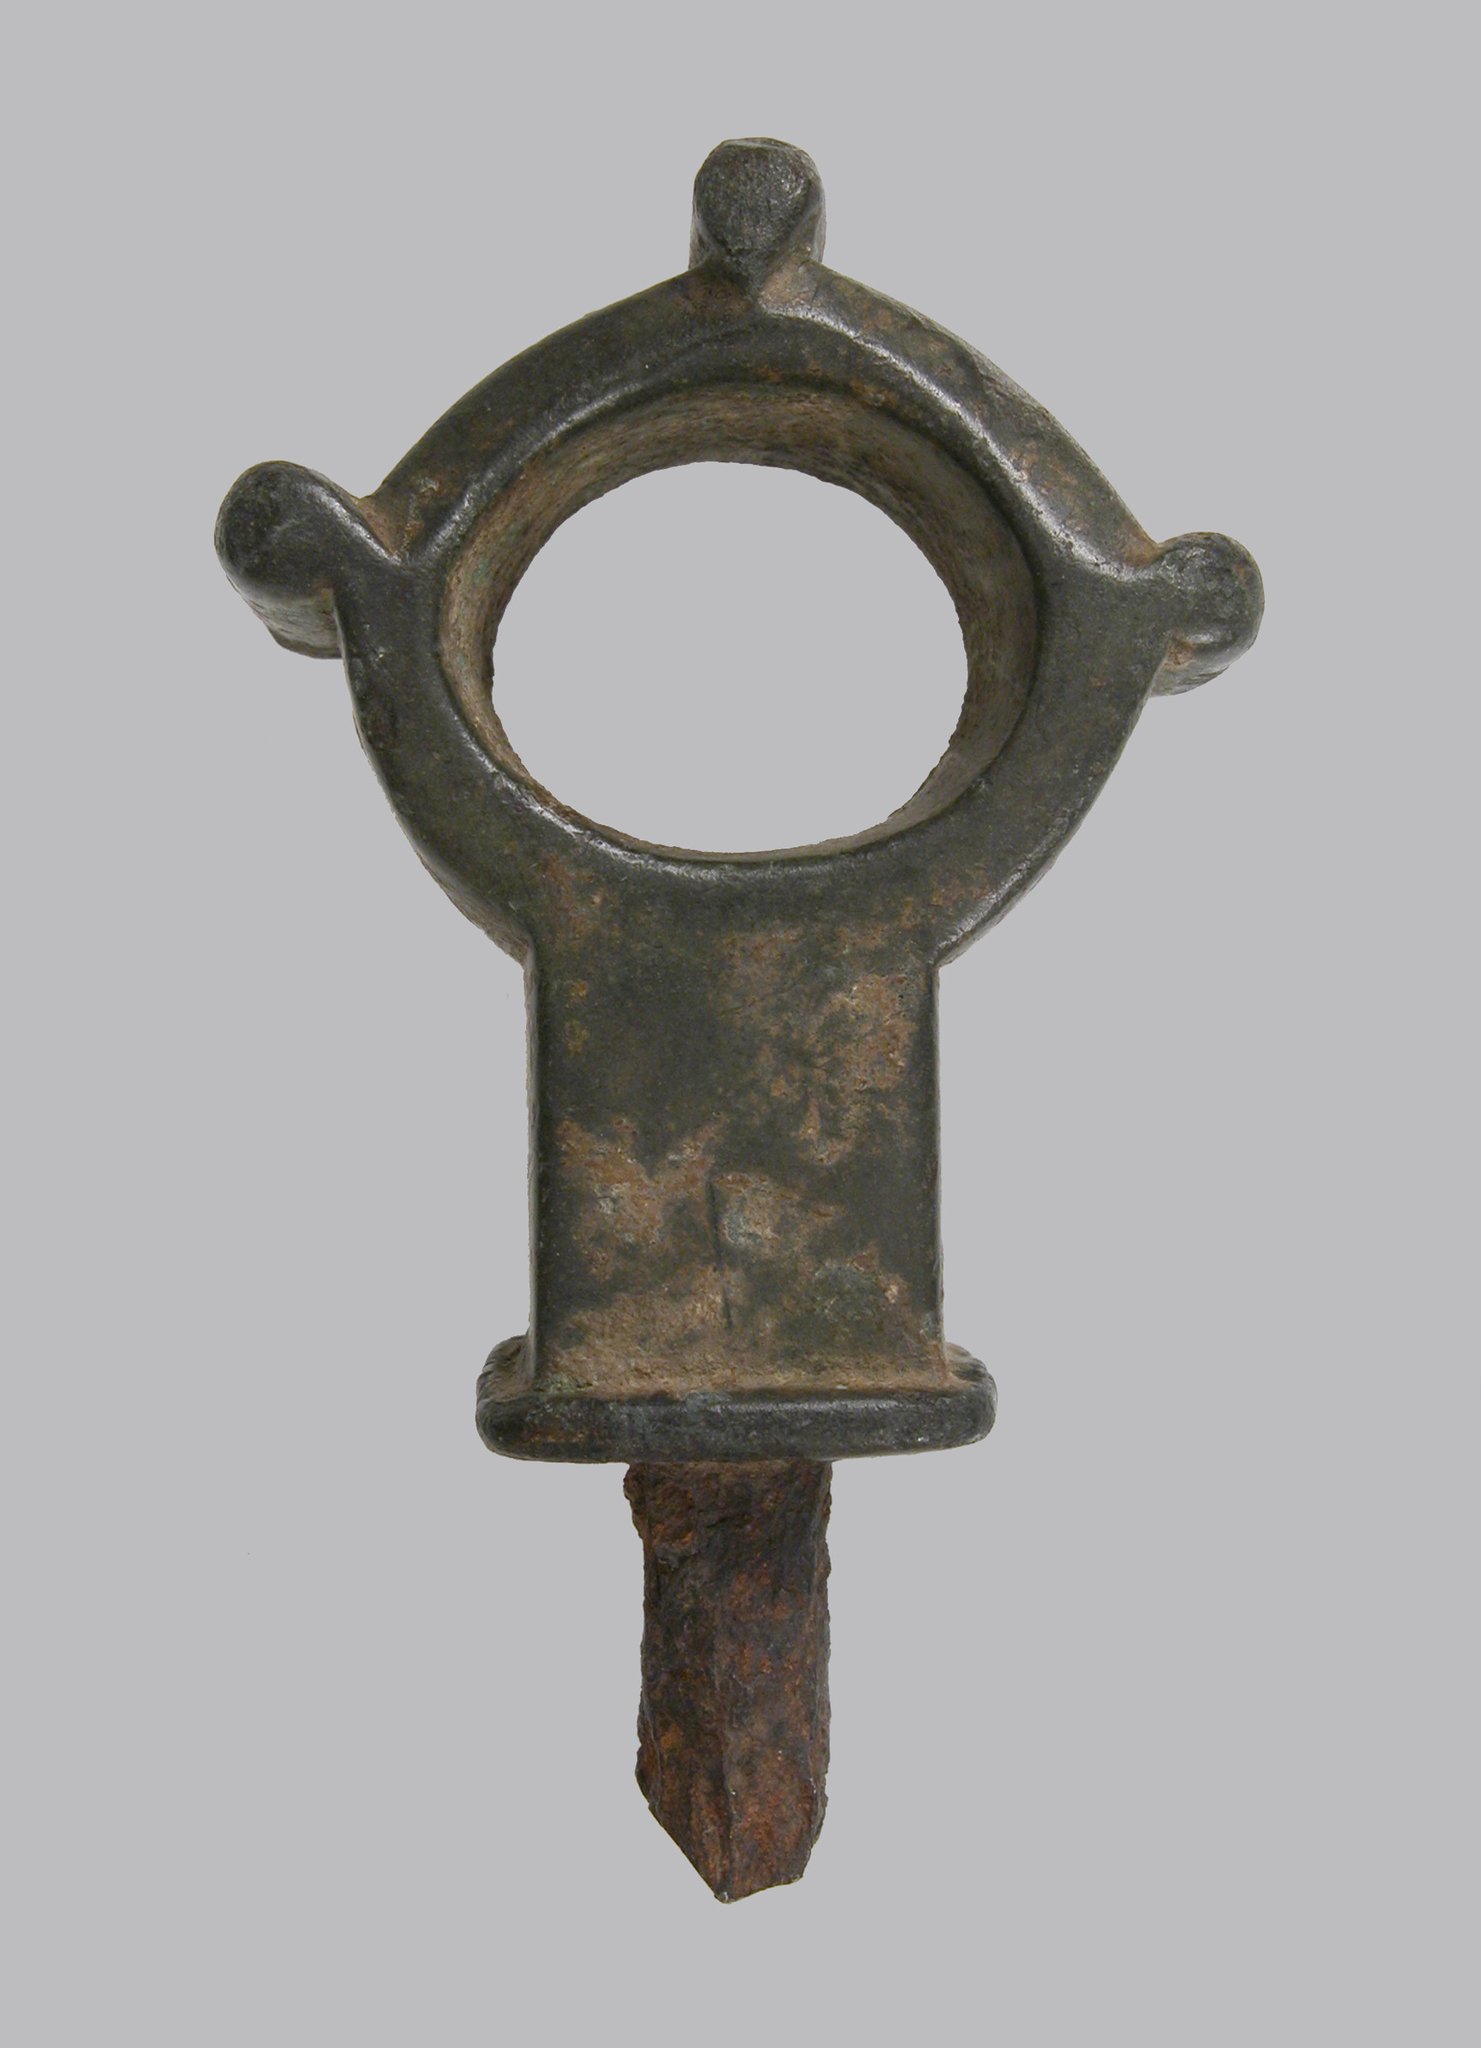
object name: key handle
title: Key-Handle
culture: roman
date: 1-700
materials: copper alloy, iron